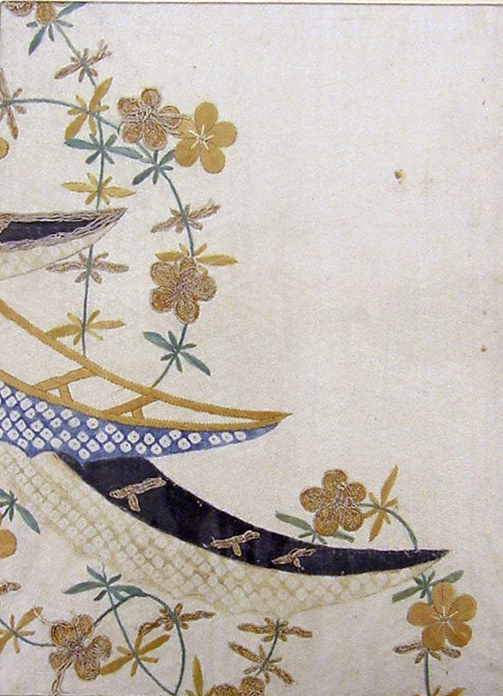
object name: piece from a kosode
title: Piece from a Kosode with Boats and Flowers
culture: japanese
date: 1615-1868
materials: metal thread, silk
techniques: damask, dyeing, embroidery, painting, resist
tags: flowers,boats